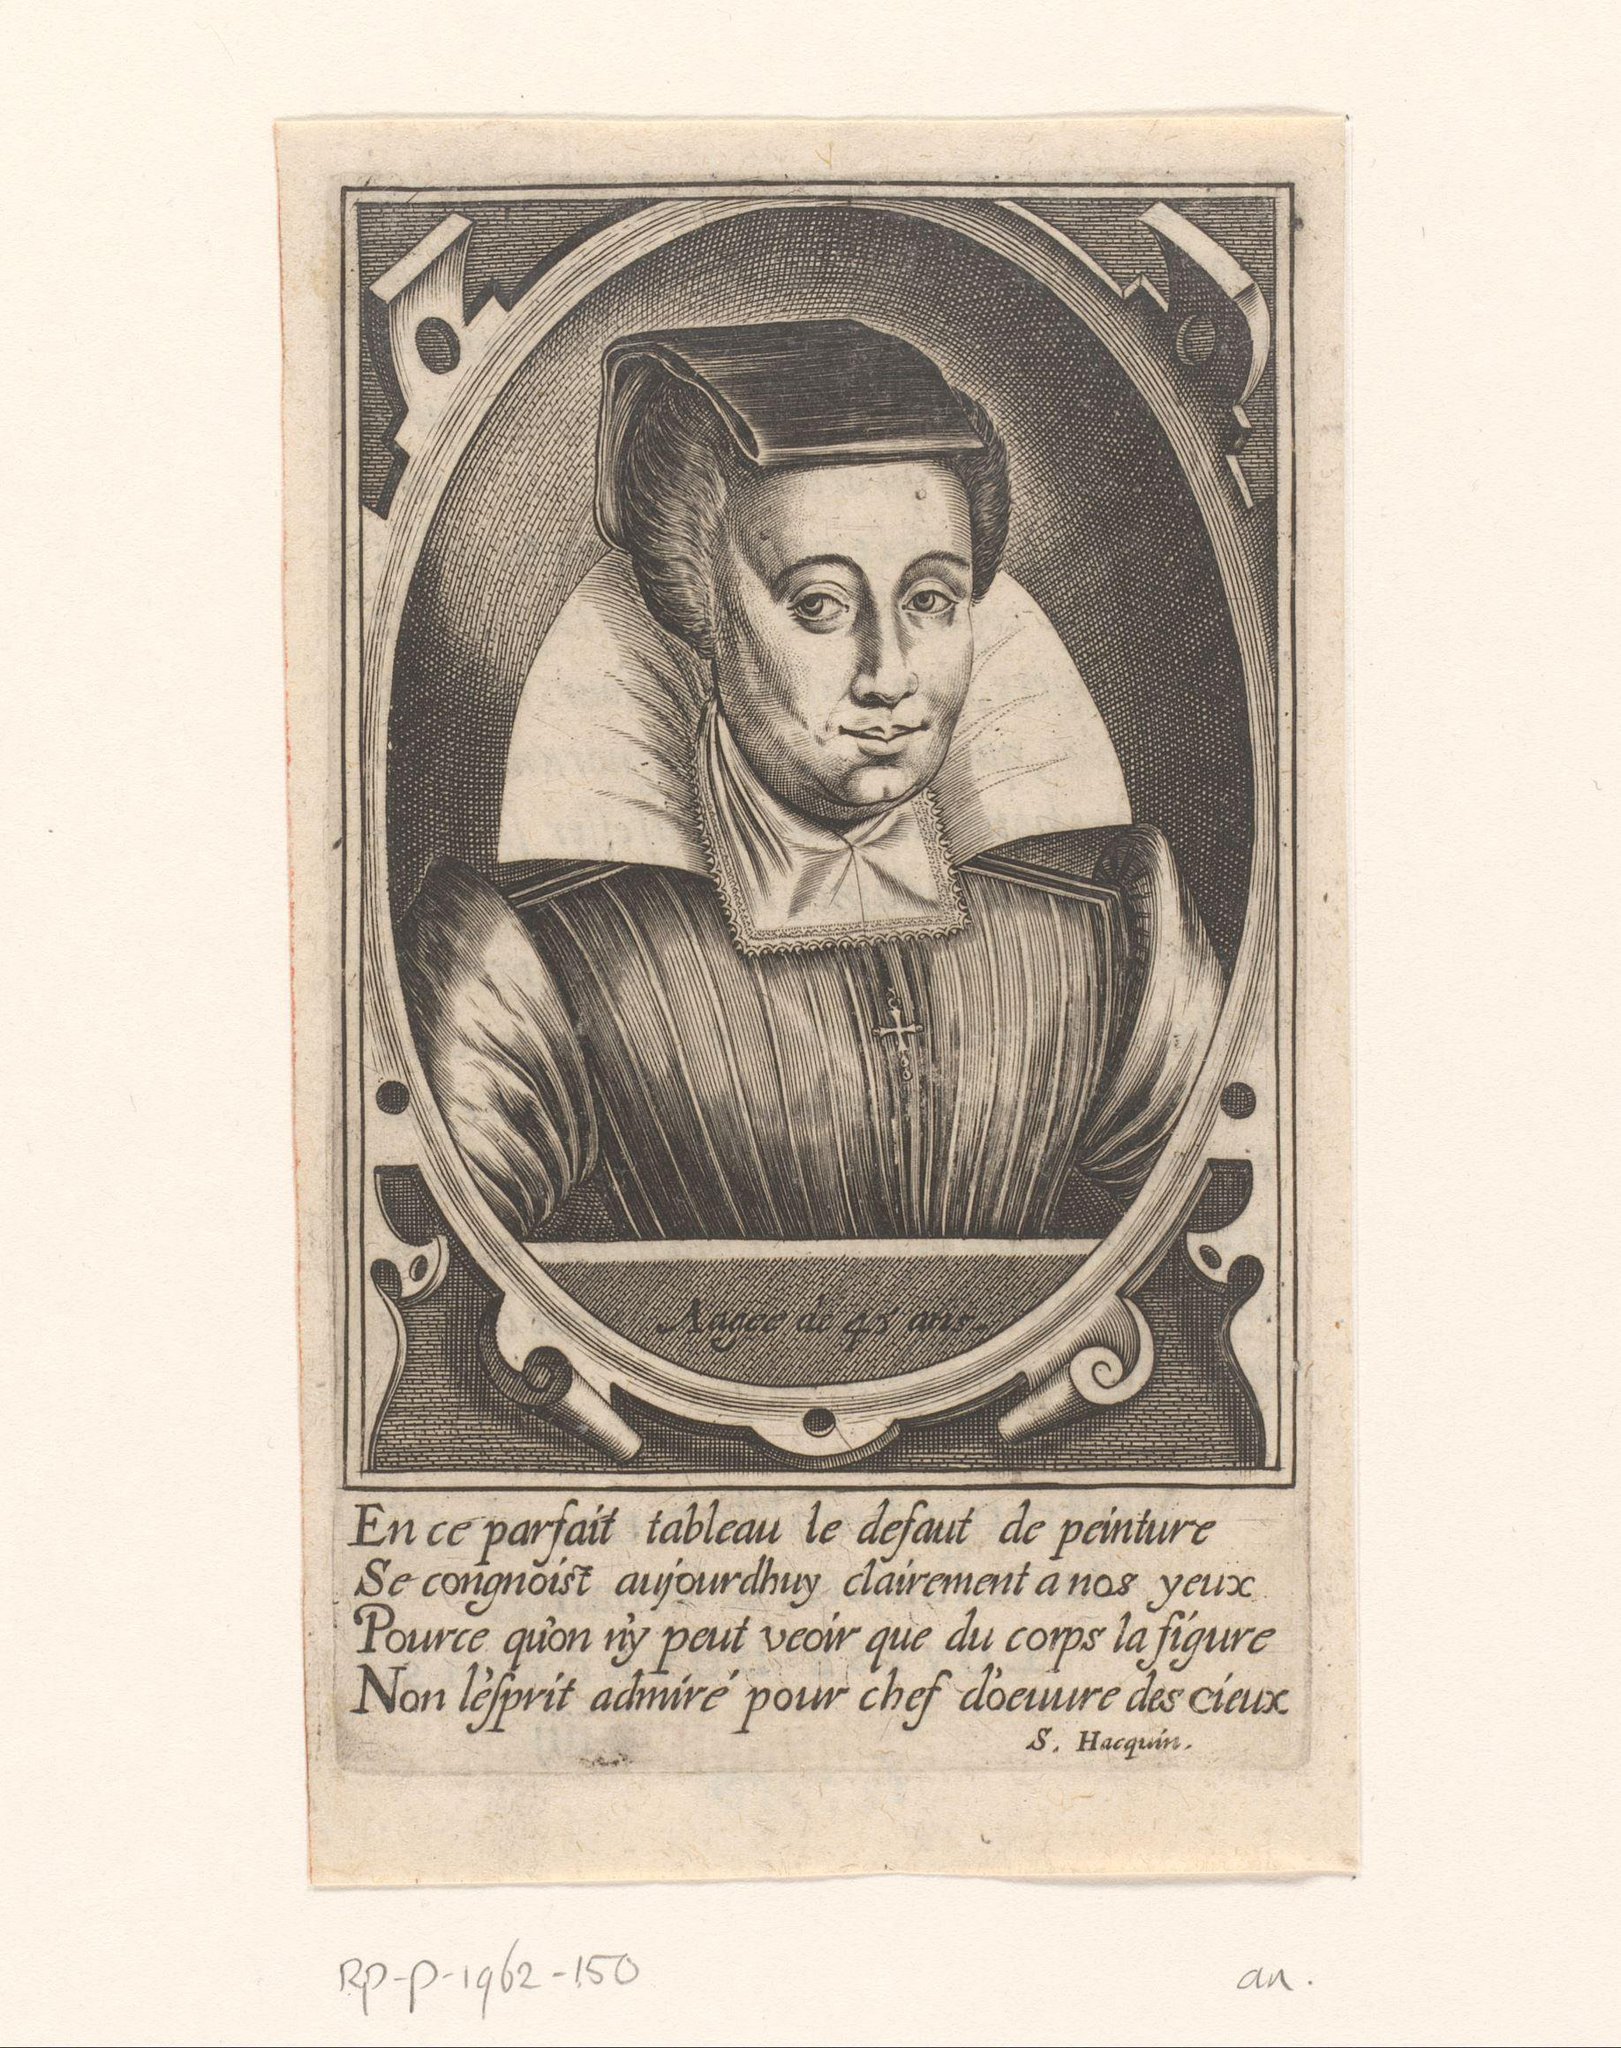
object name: book illustration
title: Portret van Louise Bourgeois op 45-jarige leeftijd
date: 1609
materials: paper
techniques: engraving, letterpress printing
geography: france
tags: historical persons - bb - woman, midwife, 'accoucheuse'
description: Prent met dezelfde tekst op verso, maar in een andere druk, gebruikt in: Bourgeois, Louise. Observations diverses sur la sterilité (...). Parijs: Abraham Saugrain, 1609.